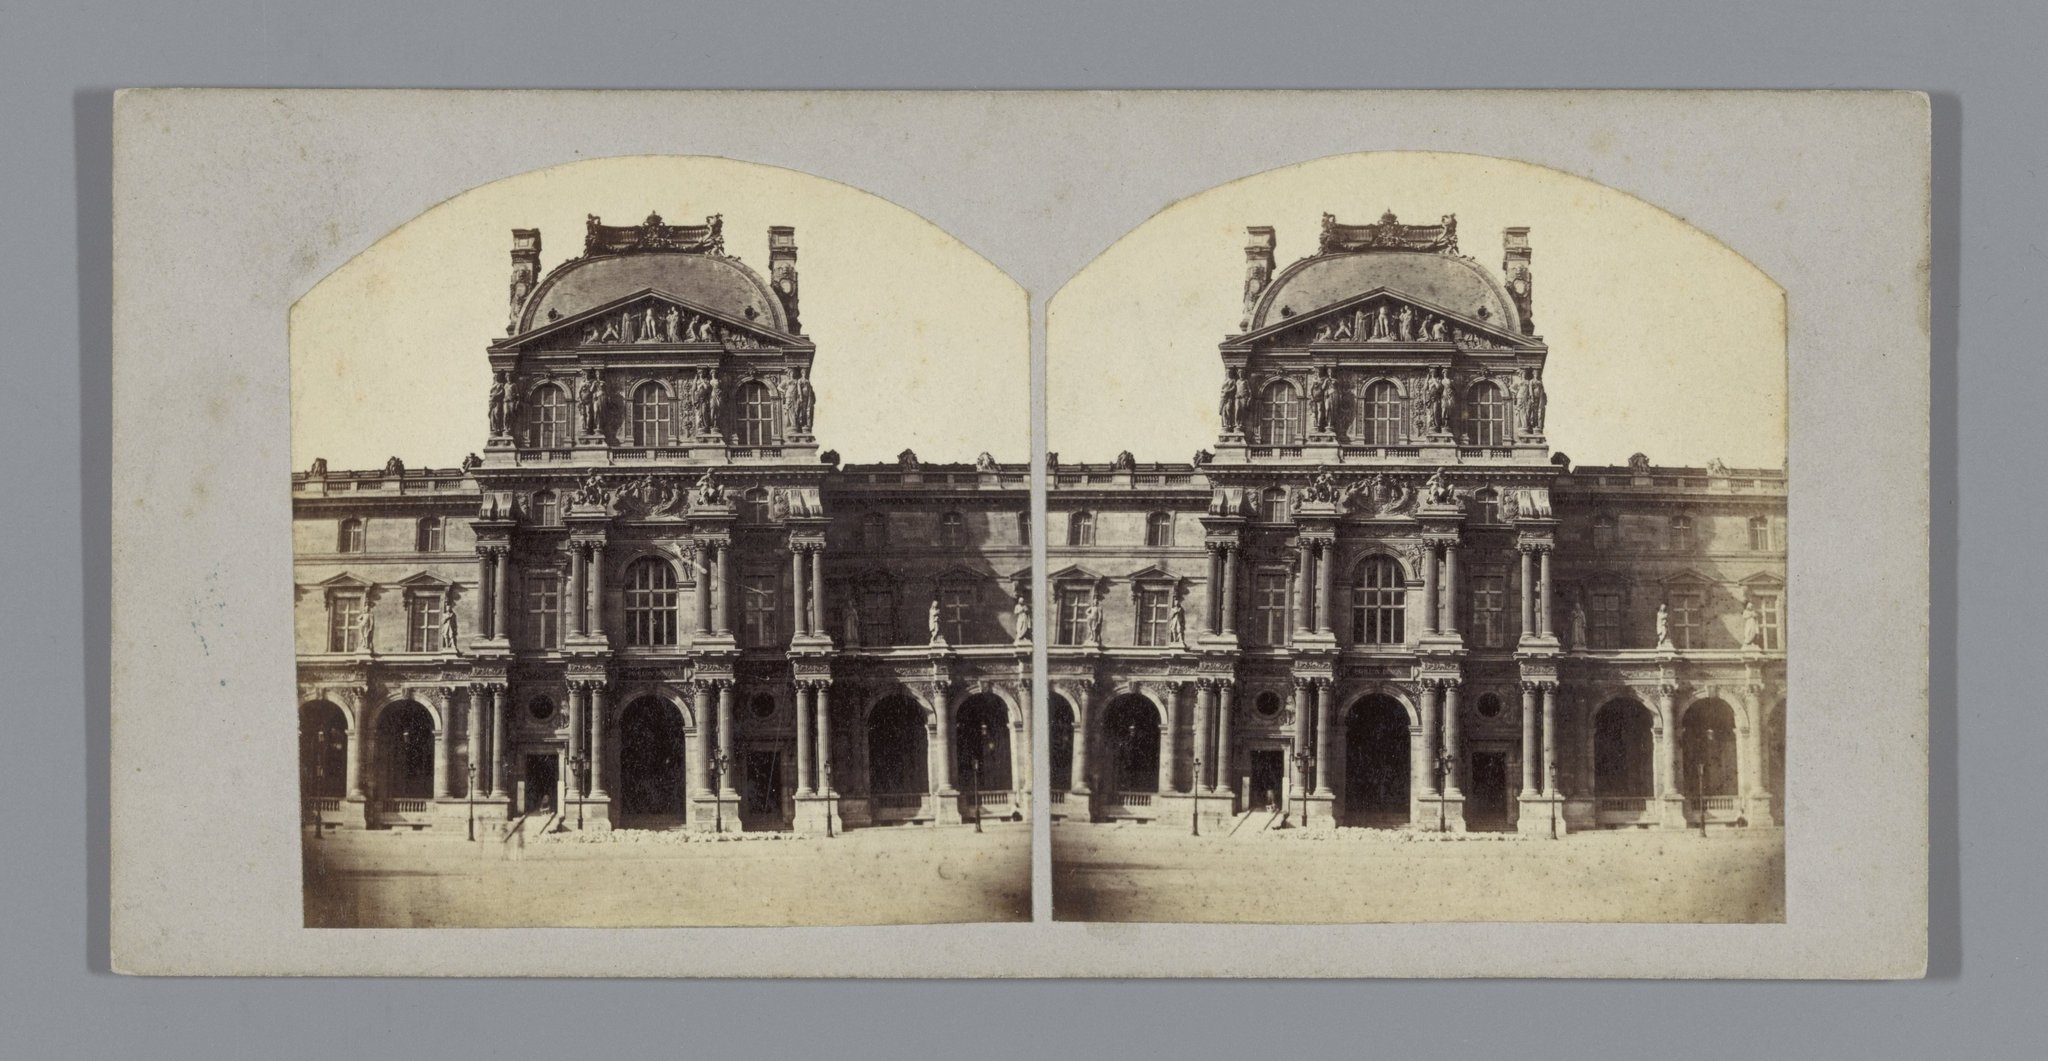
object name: stereograph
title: Le Louvre Pavillion Denon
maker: Anonymous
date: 1860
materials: cardboard, photographic support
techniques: albumen print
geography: paris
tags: permanent exhibition, museum